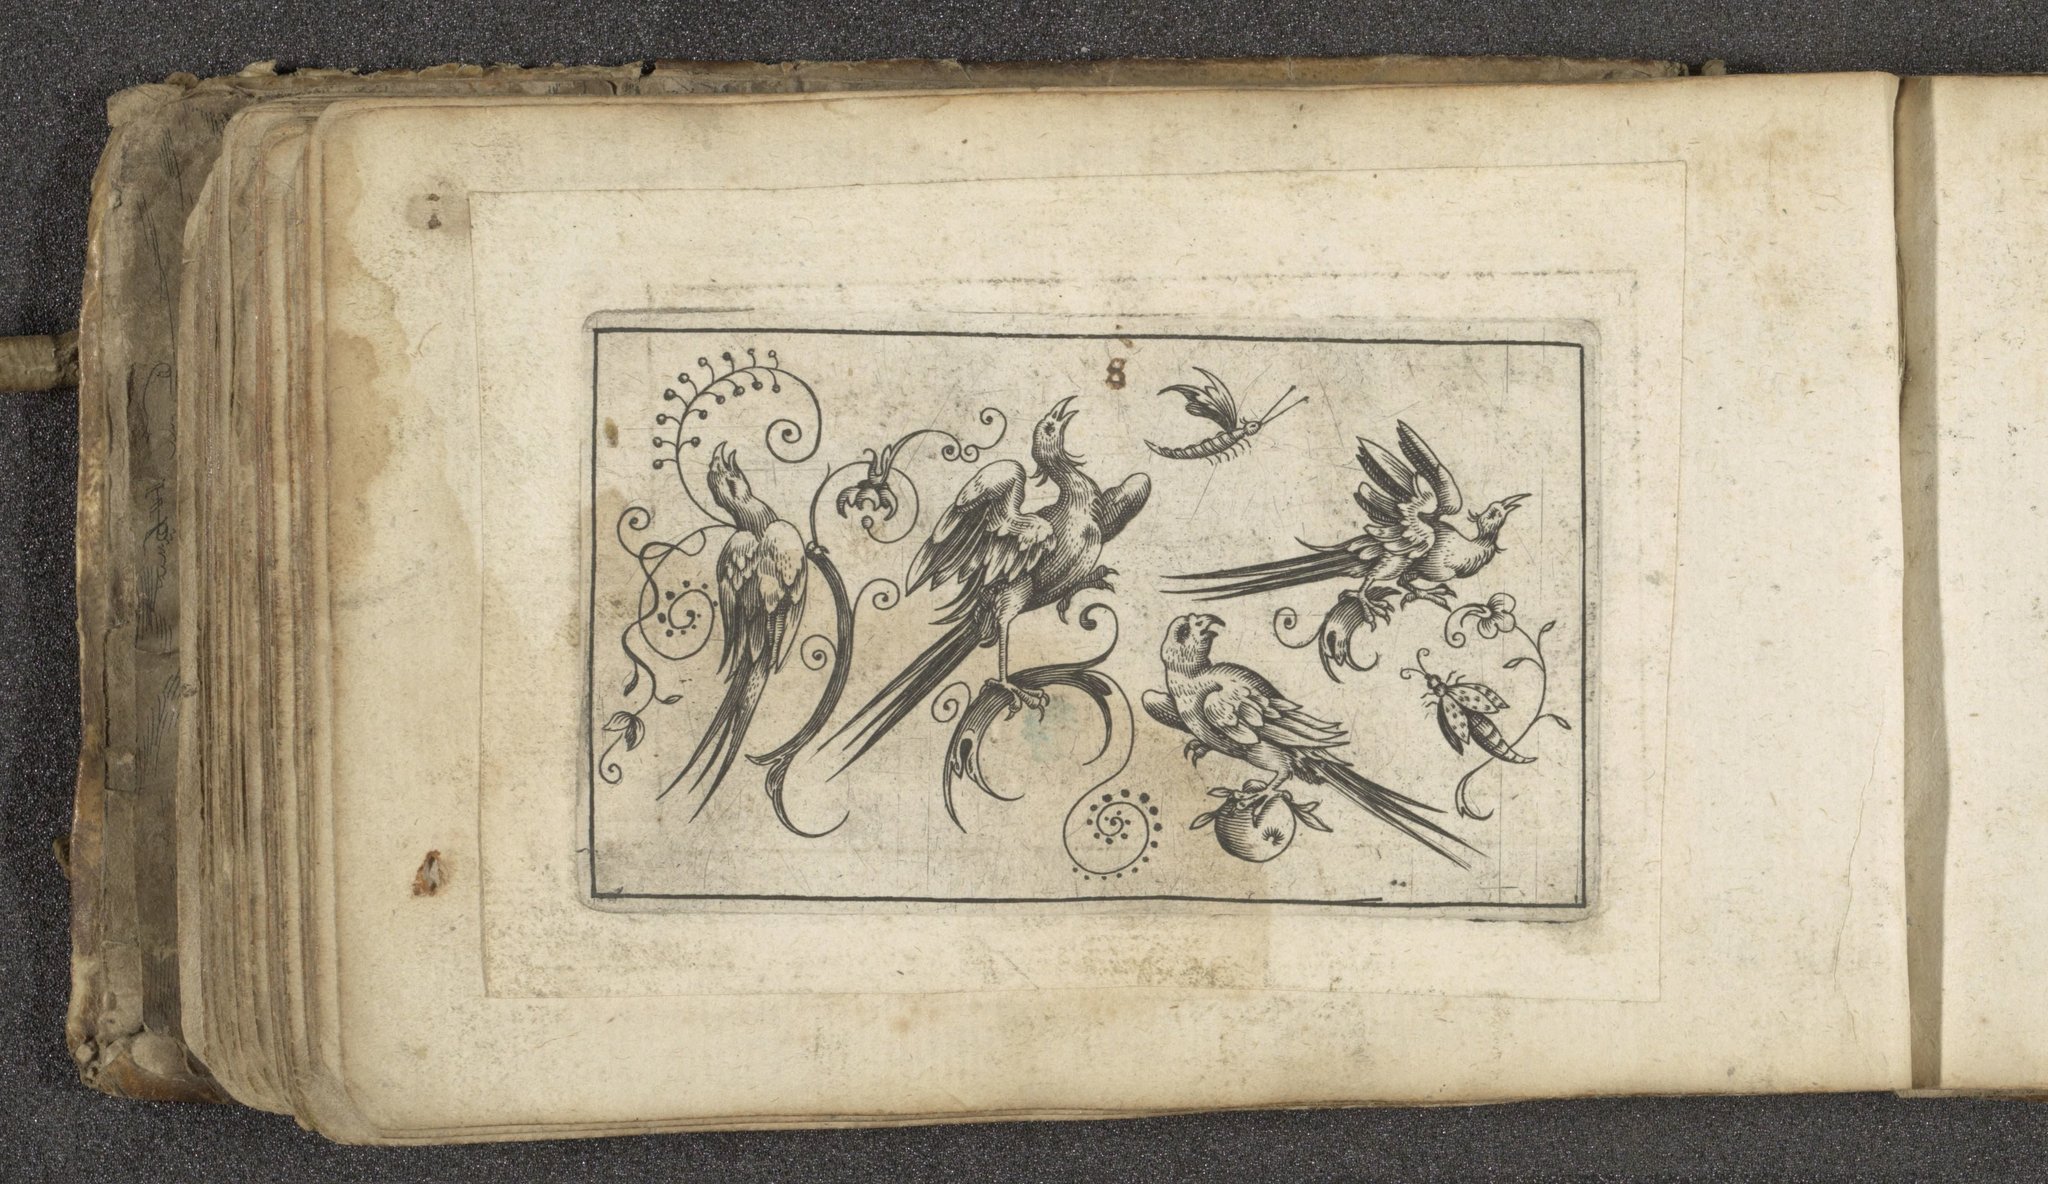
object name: album leaf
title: Vogels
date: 1601-1650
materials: paper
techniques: engraving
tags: birds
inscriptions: inscription: ‘60’, inscription: ‘8’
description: Vijf vogels op takken met ranken en fruit. Daarbij twee insecten. De prent maakt deel uit van een album.